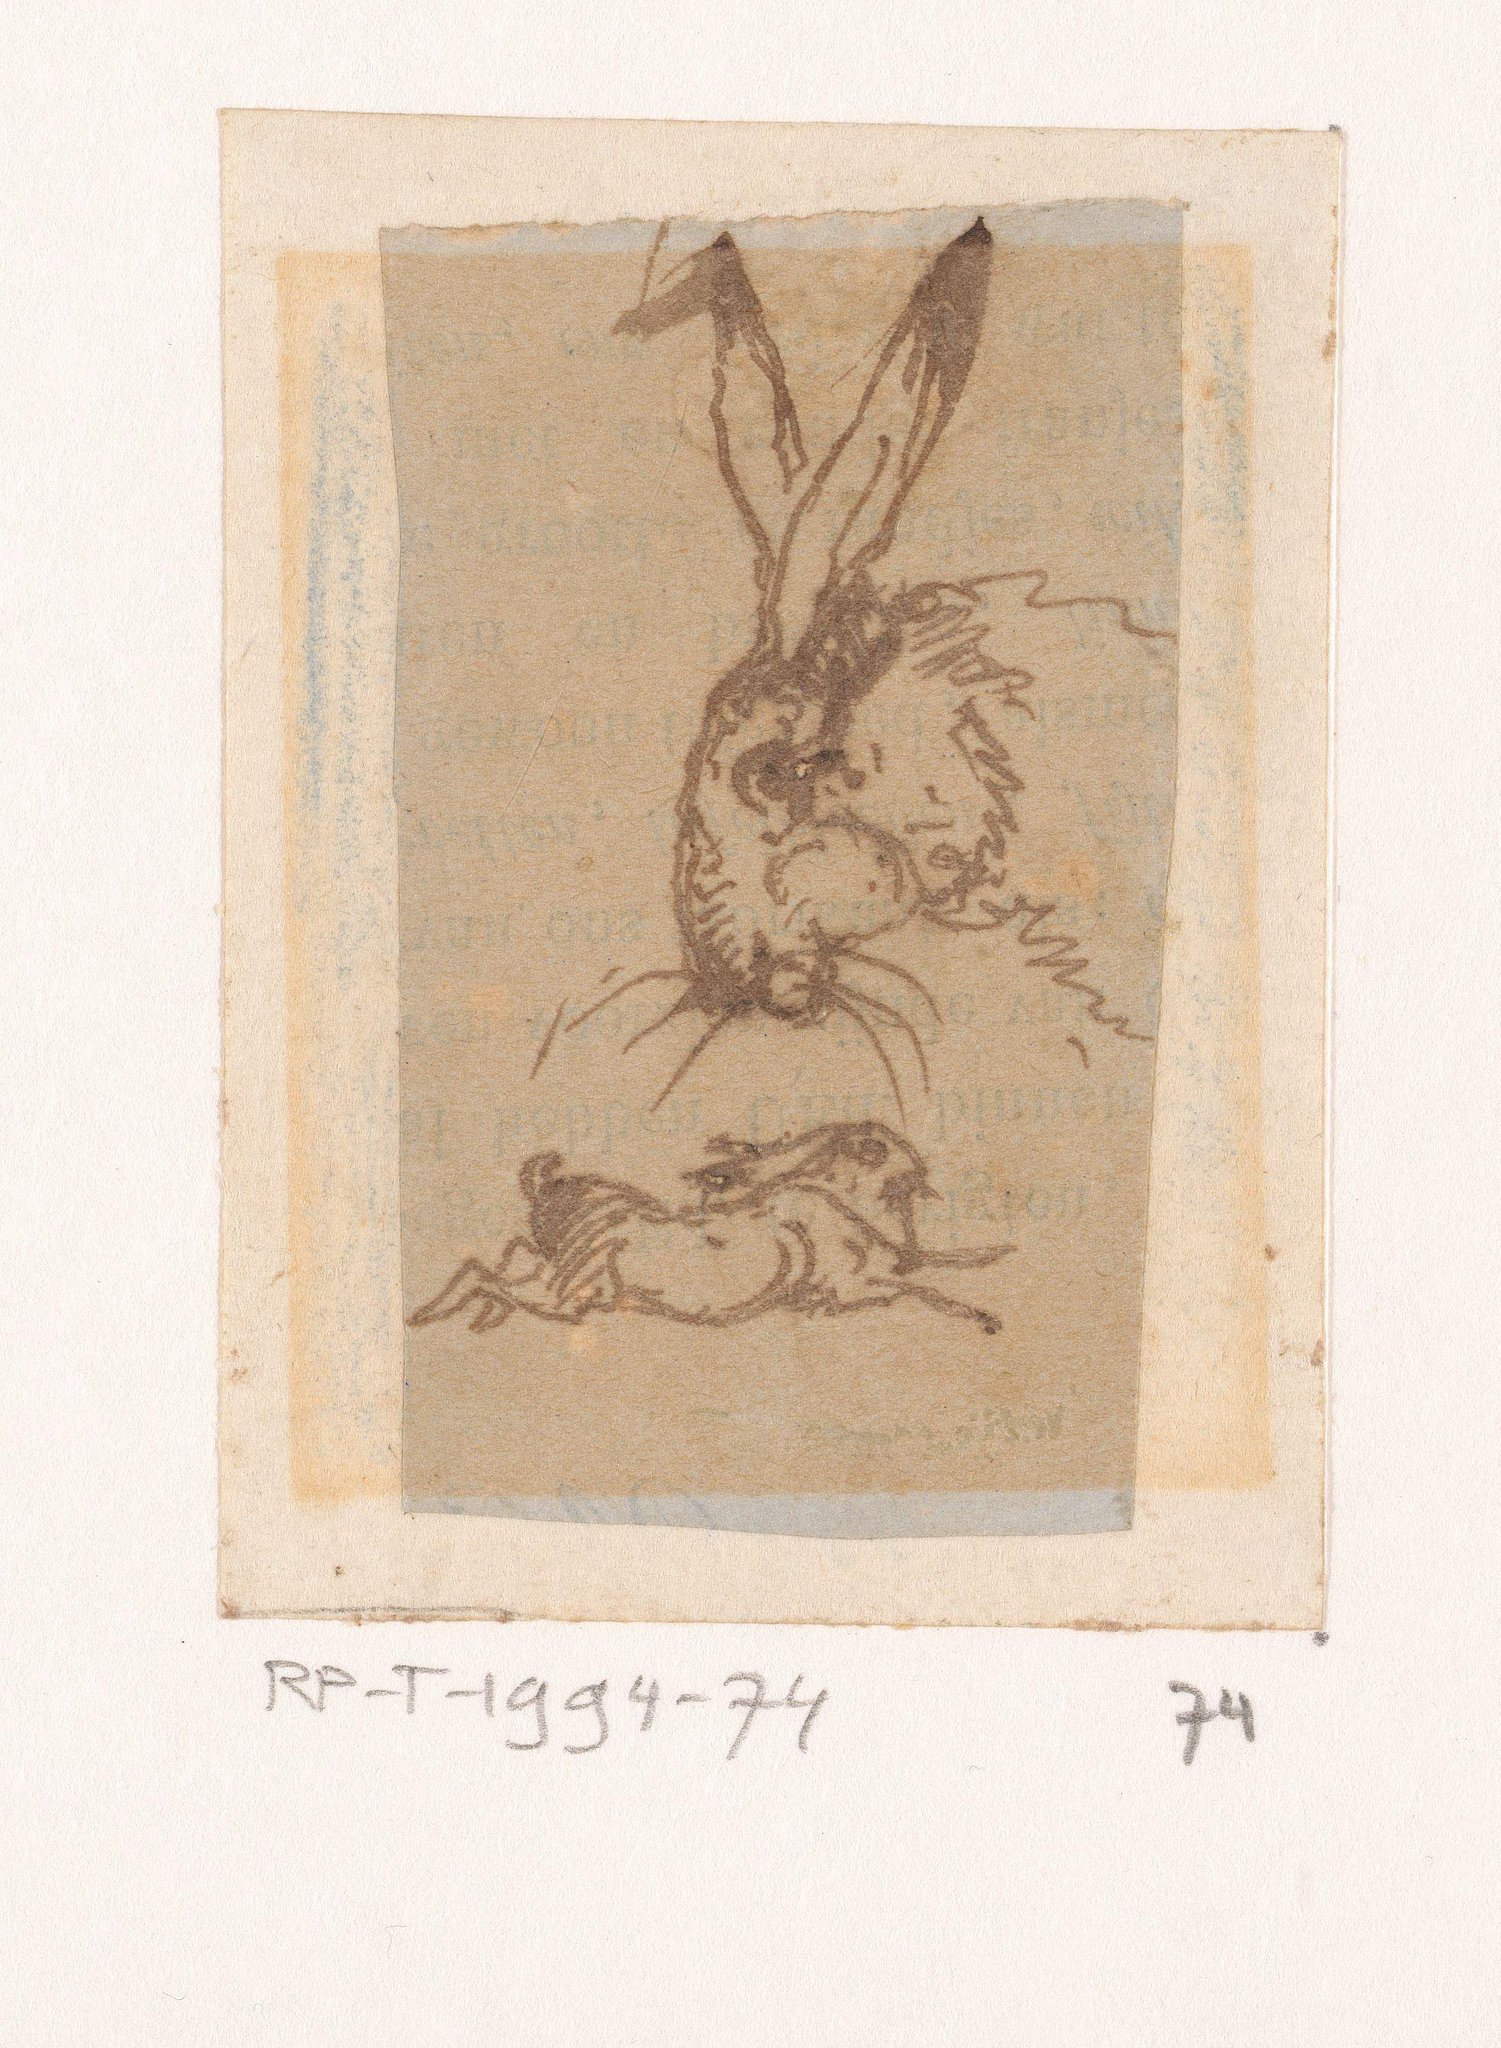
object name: drawing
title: Twee studies van hazen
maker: johannes tavenraat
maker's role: draughtsman, painter, print maker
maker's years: 1809-1881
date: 1819-1881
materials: ink, paper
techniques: pen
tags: rodents: hare